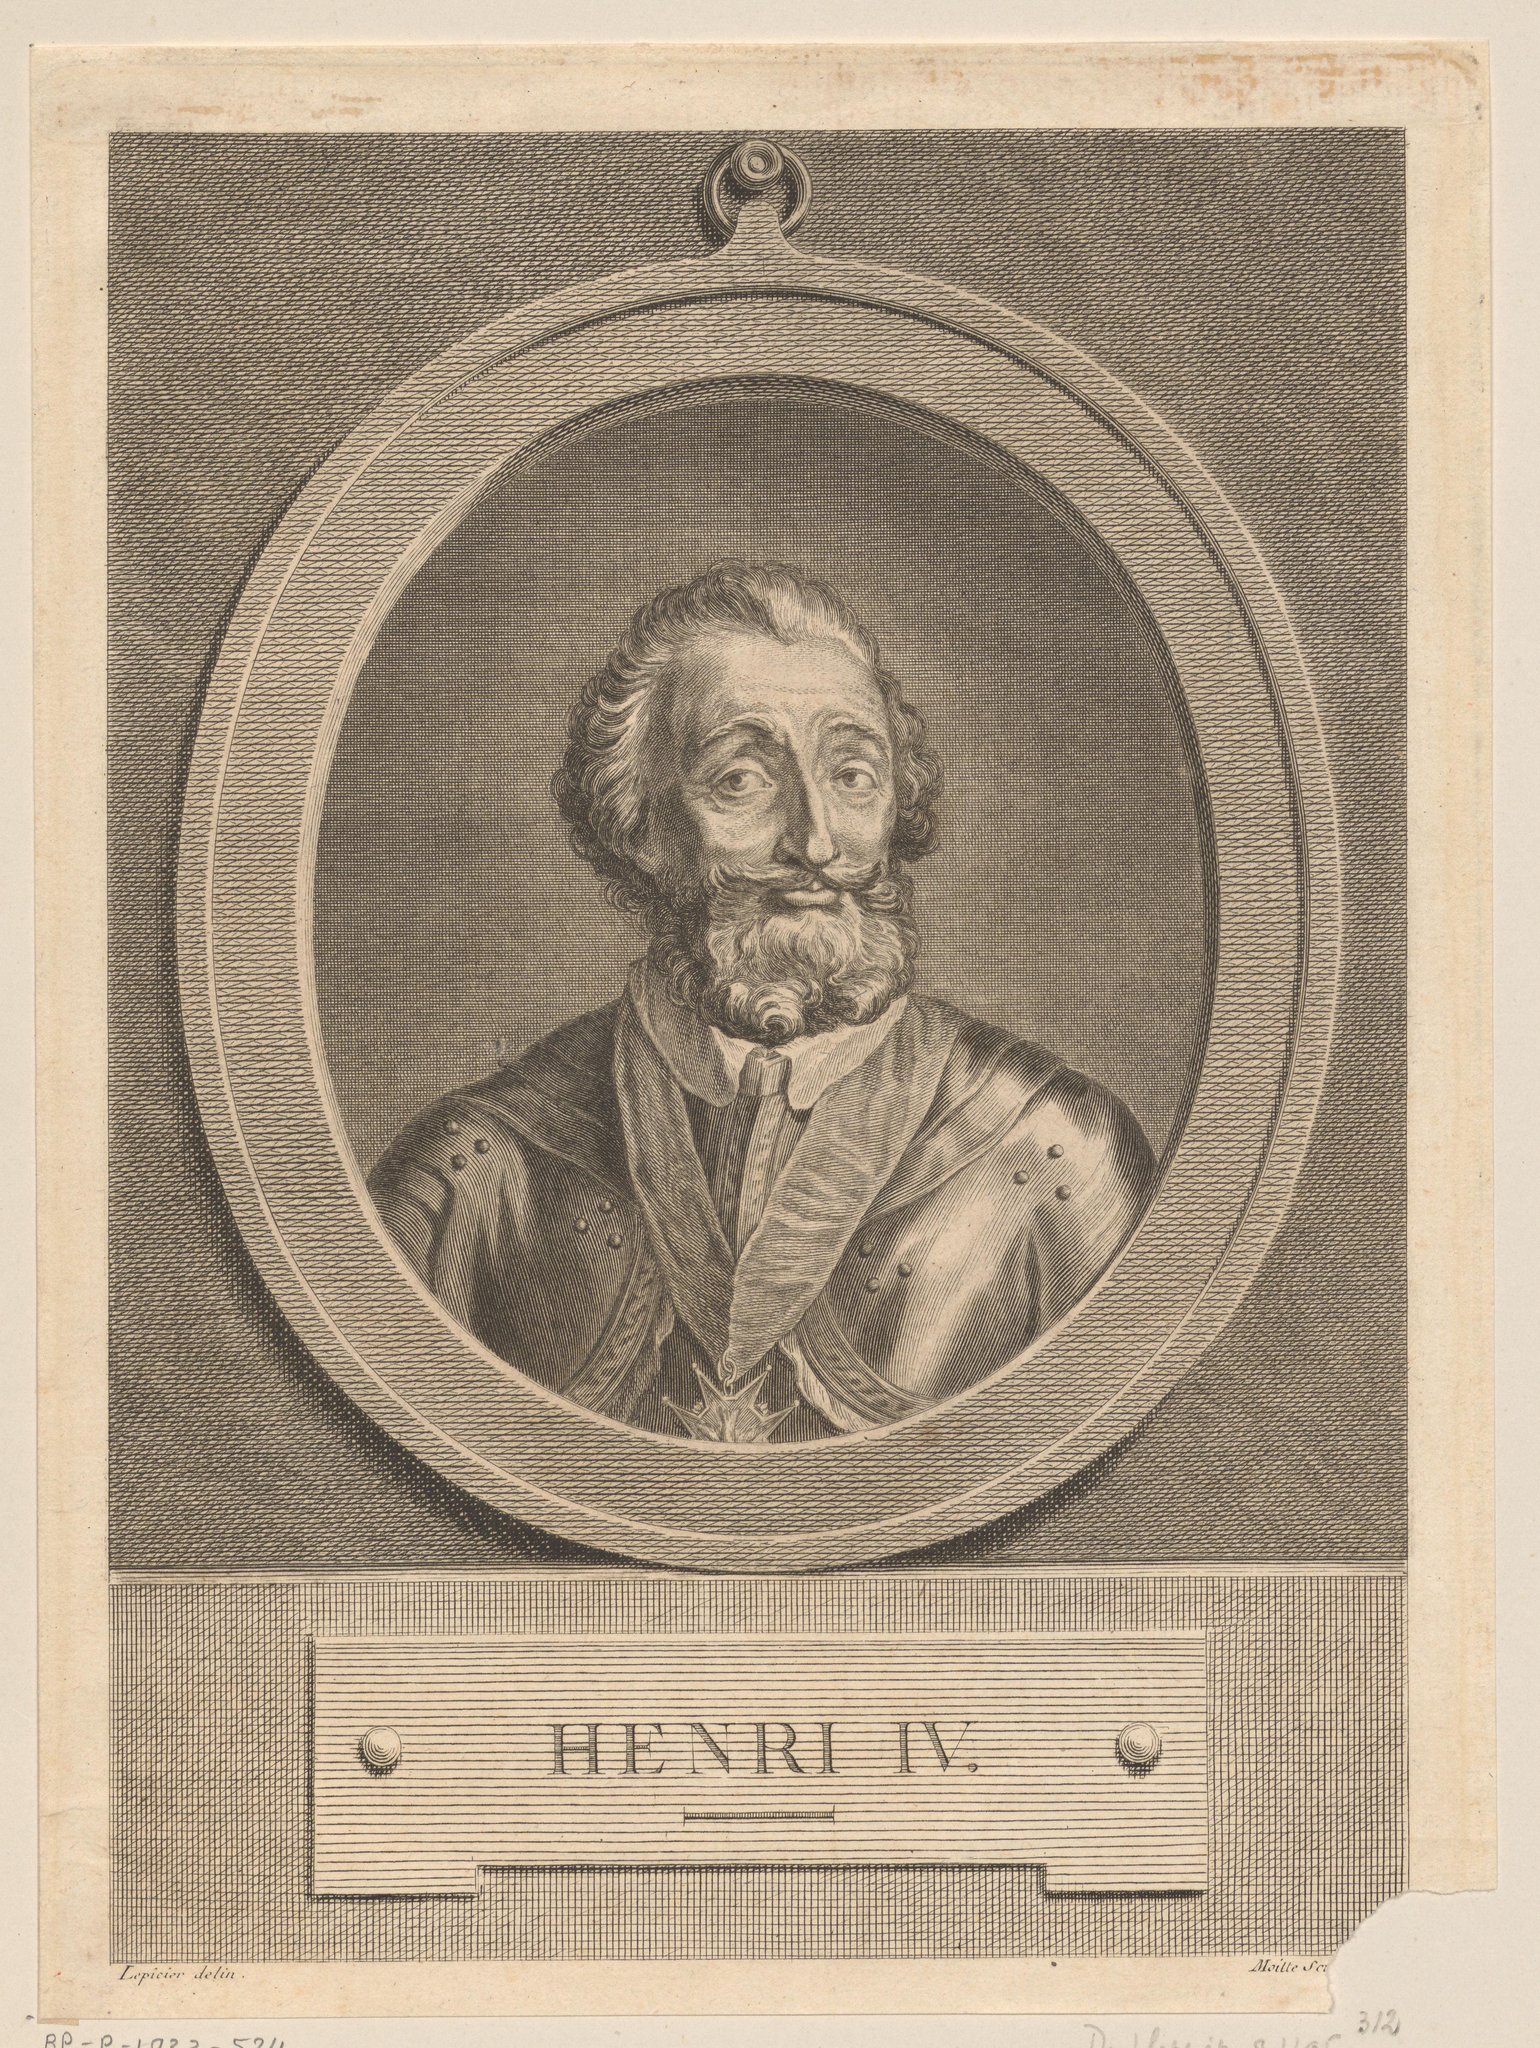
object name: print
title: Portret van Hendrik IV, koning van Frankrijk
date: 1750-1799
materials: paper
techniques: engraving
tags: hendrik iv (koning van frankrijk en navarra), historical persons, king